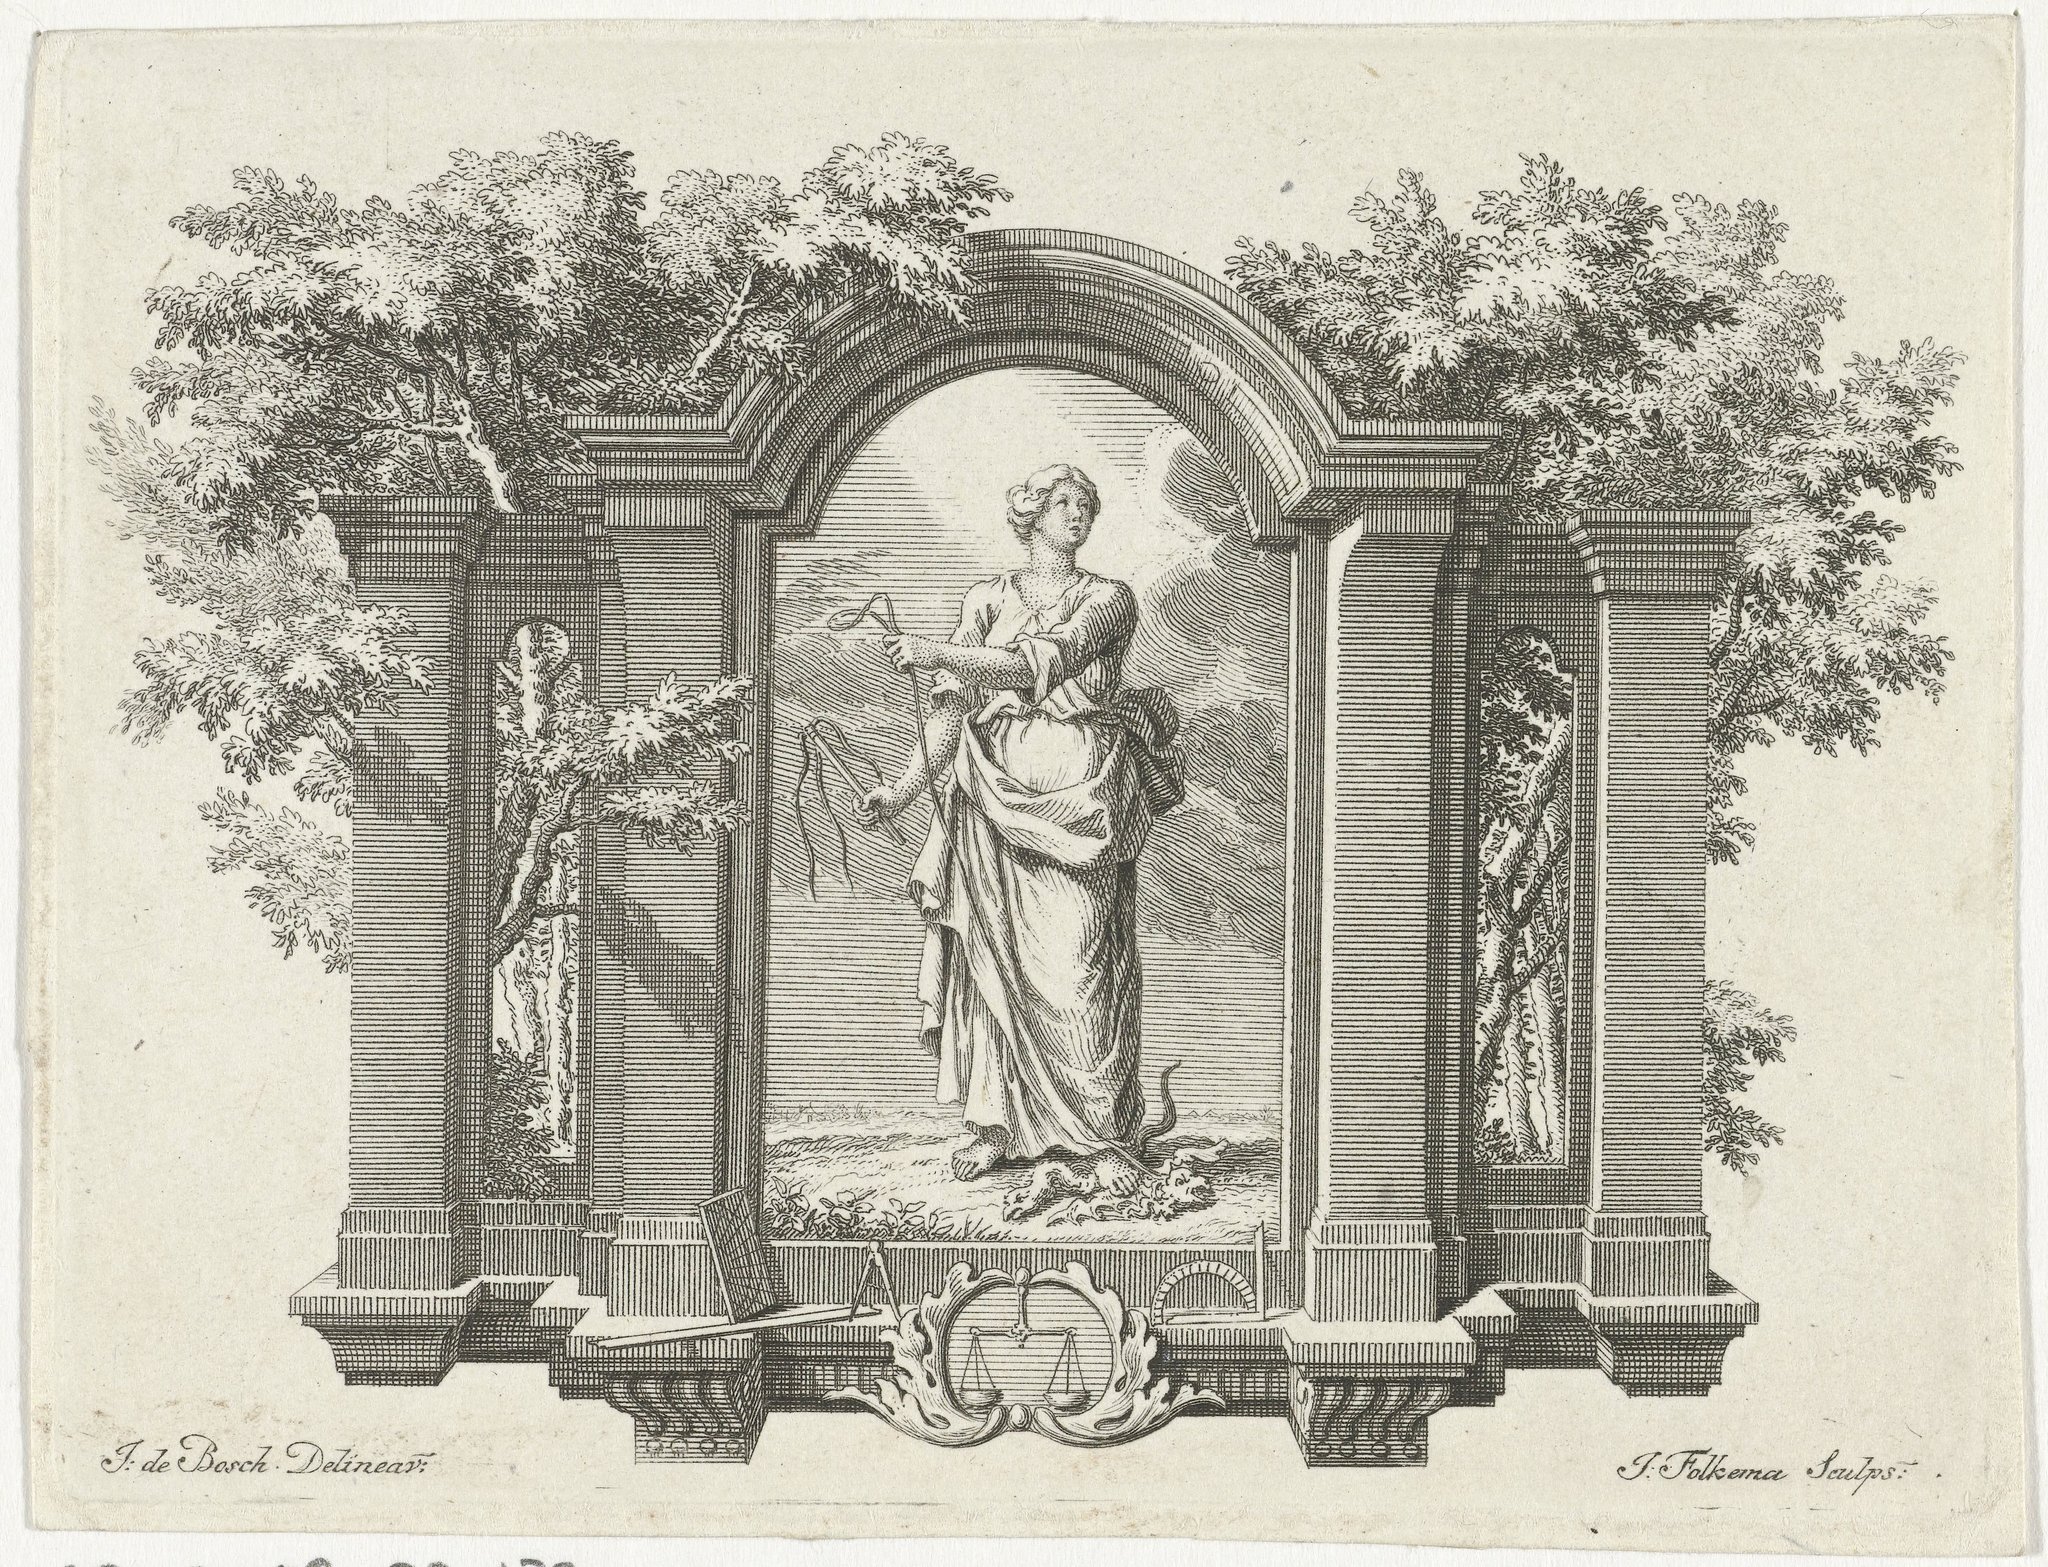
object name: print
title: Vignet met de personificatie van de Rede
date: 1723-1767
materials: paper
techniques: etching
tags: reason; 'ragione' (ripa)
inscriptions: collector's mark: Lugt 240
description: Vignet met de beeltenis van de gepersonifieerde Rede in een architecturale omlijsting waarin onderaan een cartouche met een weegschaal is geplaatst. De Rede trapt met haar voet twee duivelse figuren tegen de grond, in haar handen houdt ze teugels en een zweep vast. De prent maakt deel uit van een reeks boekillustraties over deugden en ondeugden.